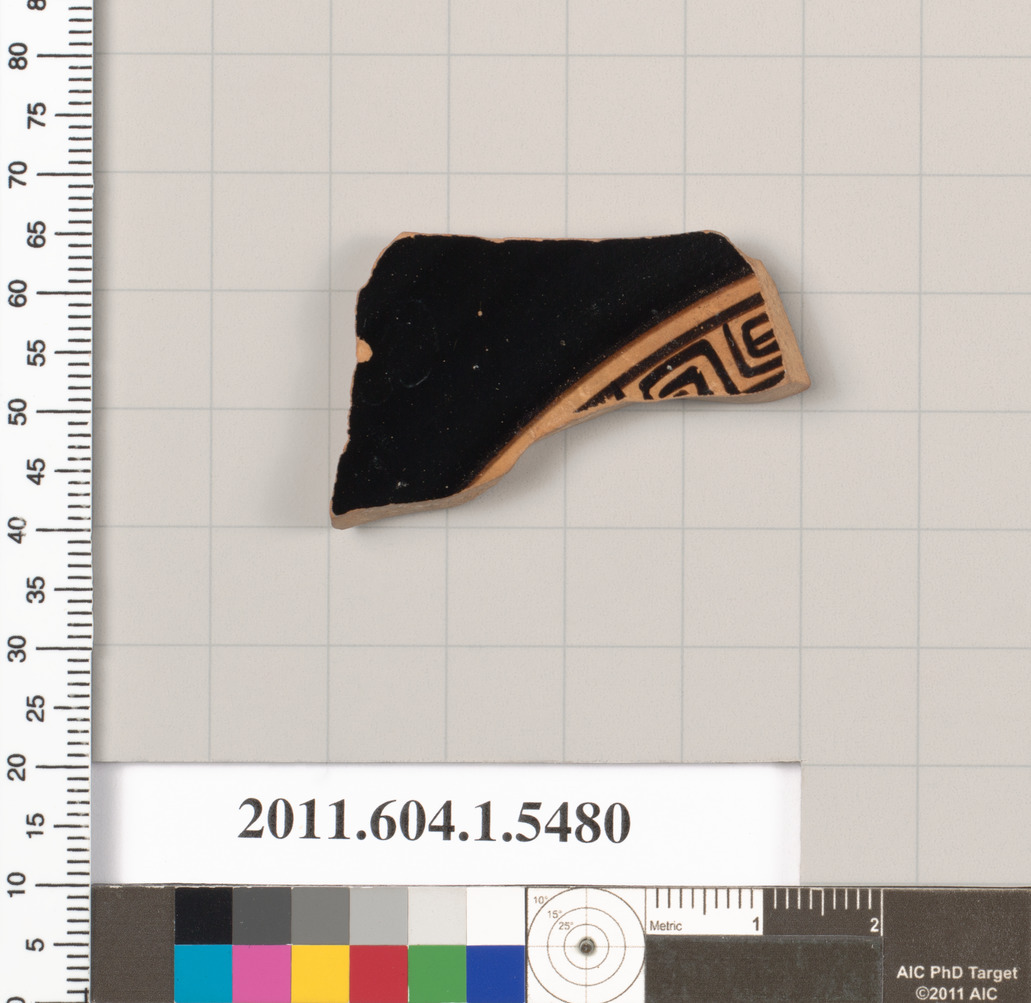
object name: kylix fragment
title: Terracotta fragment of a kylix (drinking cup)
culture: greek, attic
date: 500-480 BCE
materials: terracotta